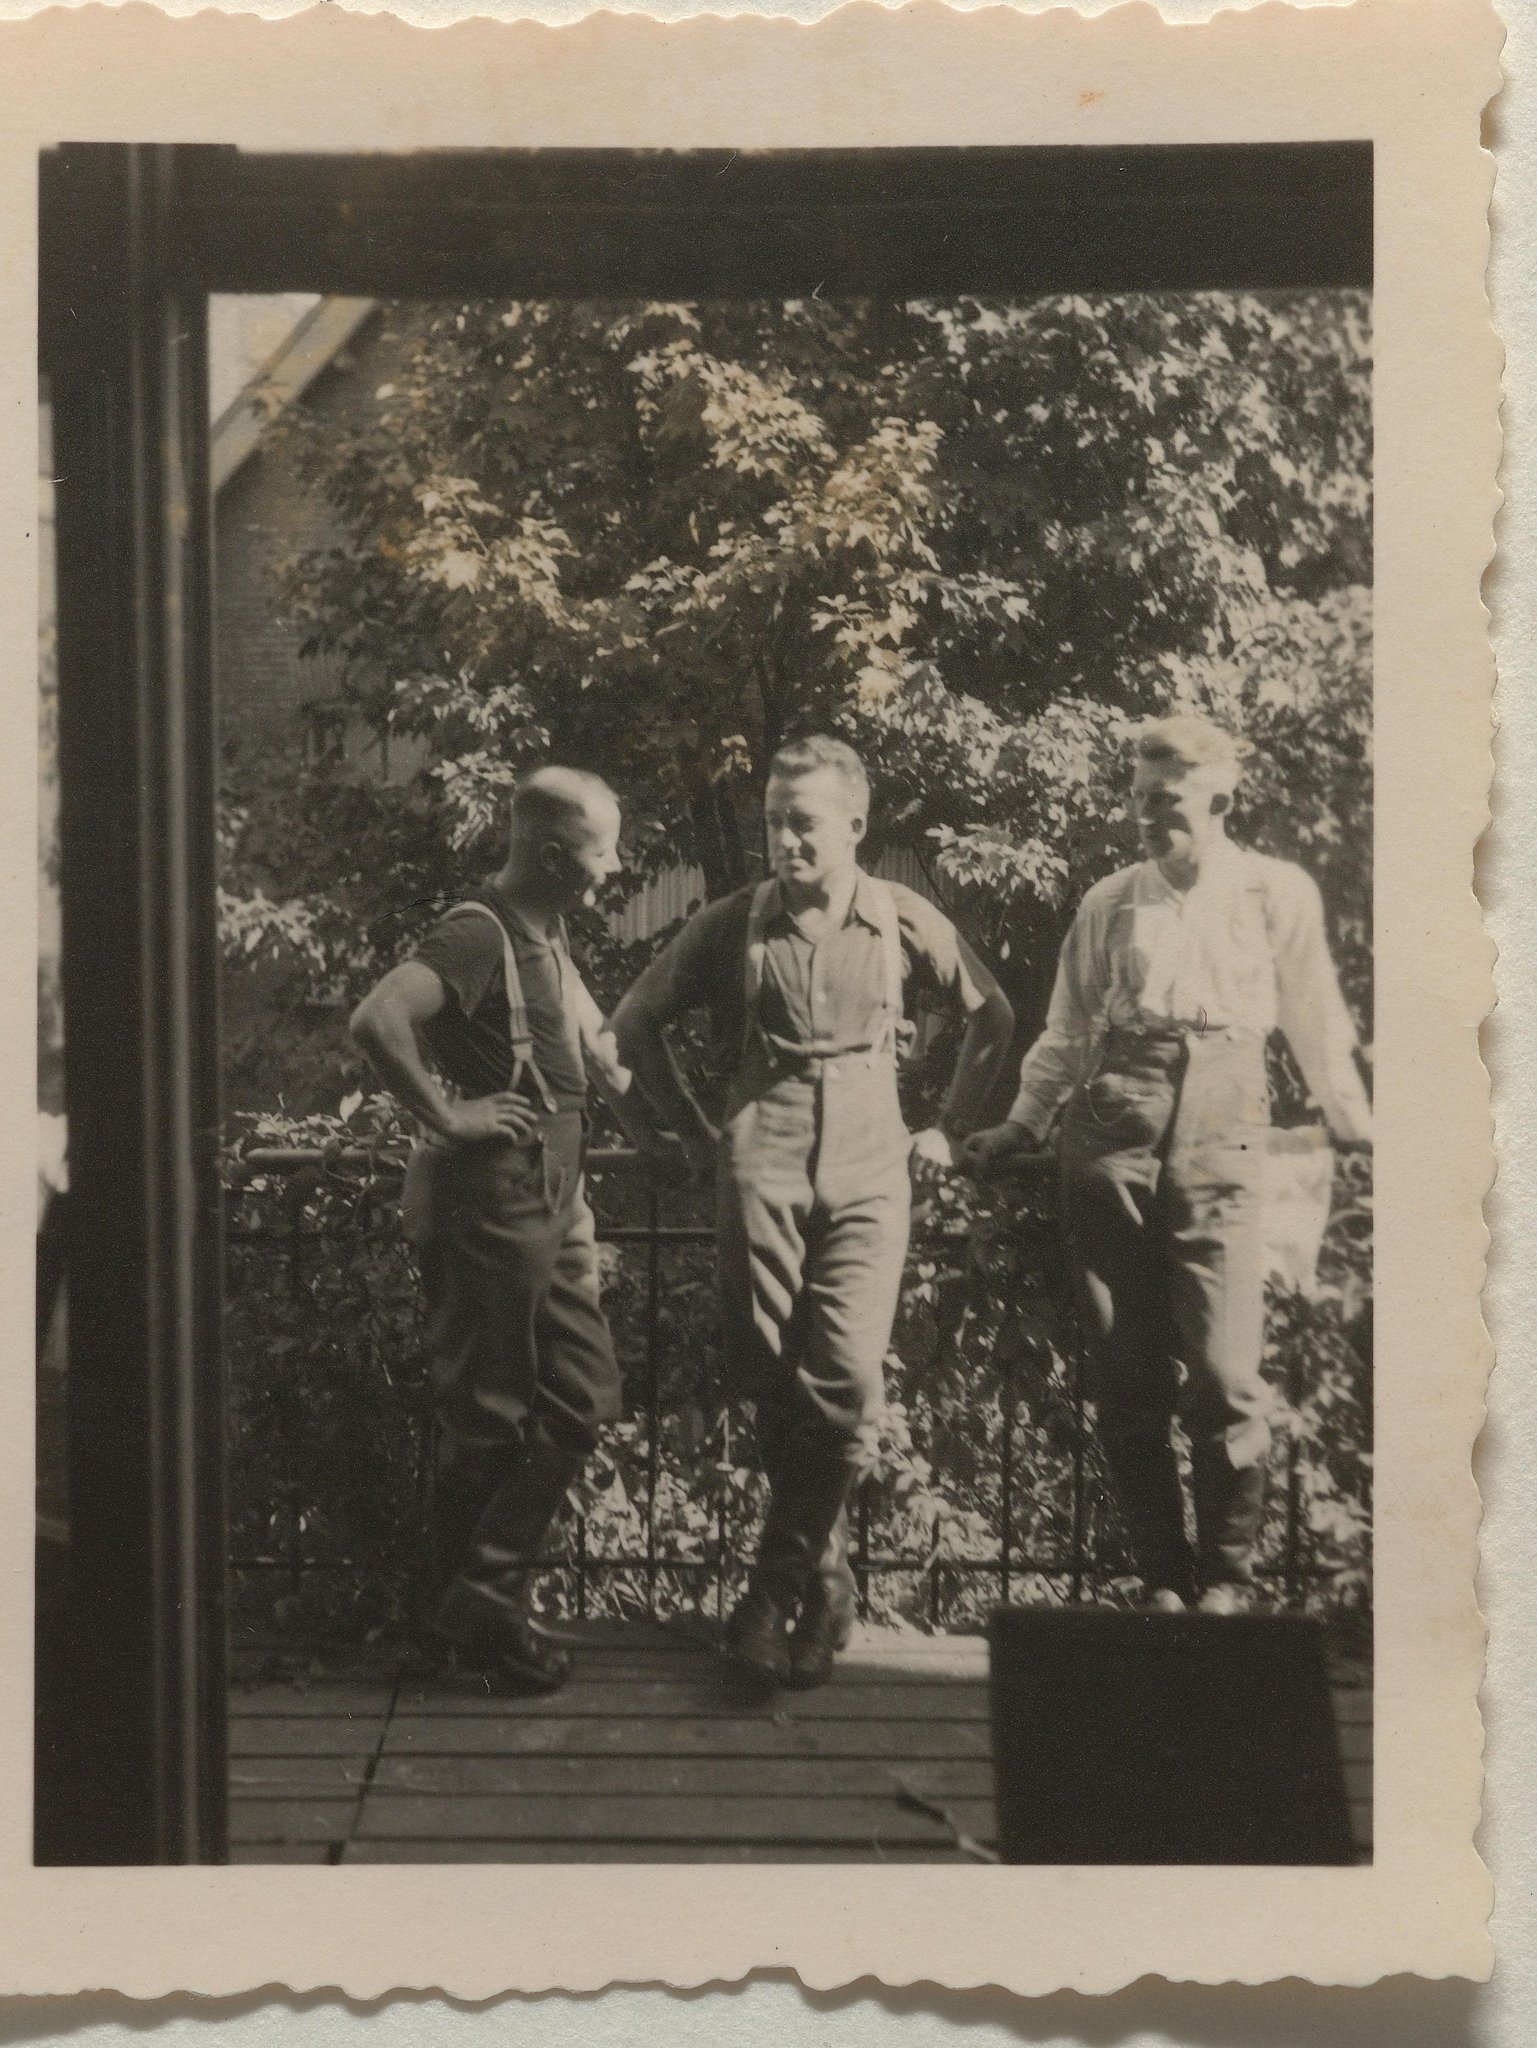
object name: photograph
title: Drie Wehrmacht militairen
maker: Anonymous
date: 1909-1940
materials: photographic support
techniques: gelatin silver print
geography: dordrecht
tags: occupier and civilians, occupation ~ war, dordrecht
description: Drie Wehrmacht militairen op een balkon. Achter hen bomen. Ze hebben alleen een militaire broek en laarzen aan. Achterop staat: Im ... Dordrecht (Holland) im Sept. 1940